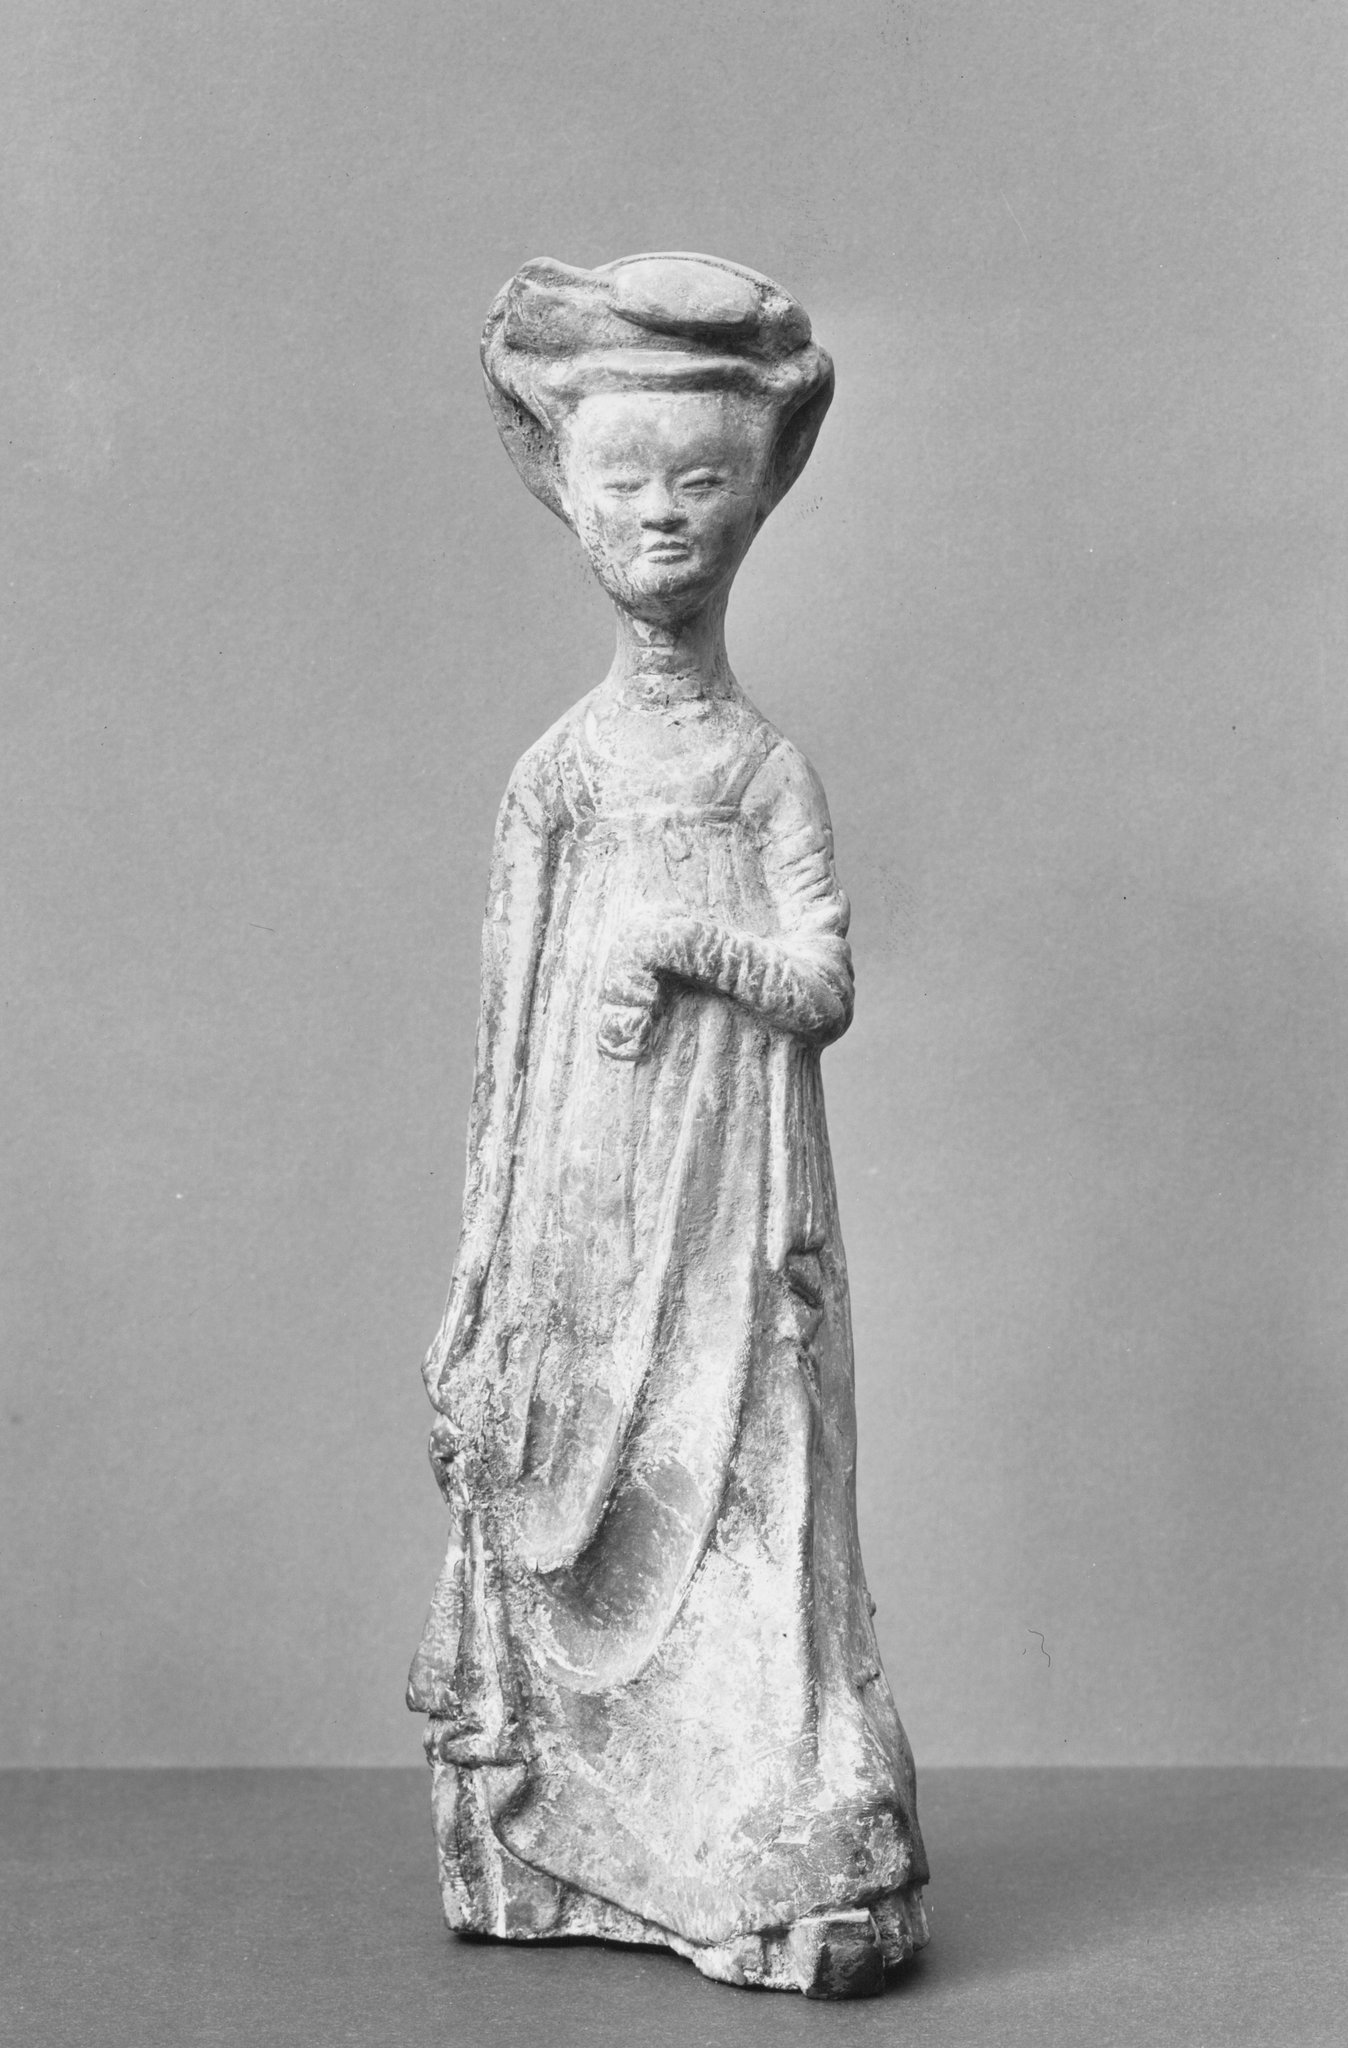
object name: figure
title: Female attendant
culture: chinese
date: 567-700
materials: earthenware, pigment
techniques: glazing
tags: women